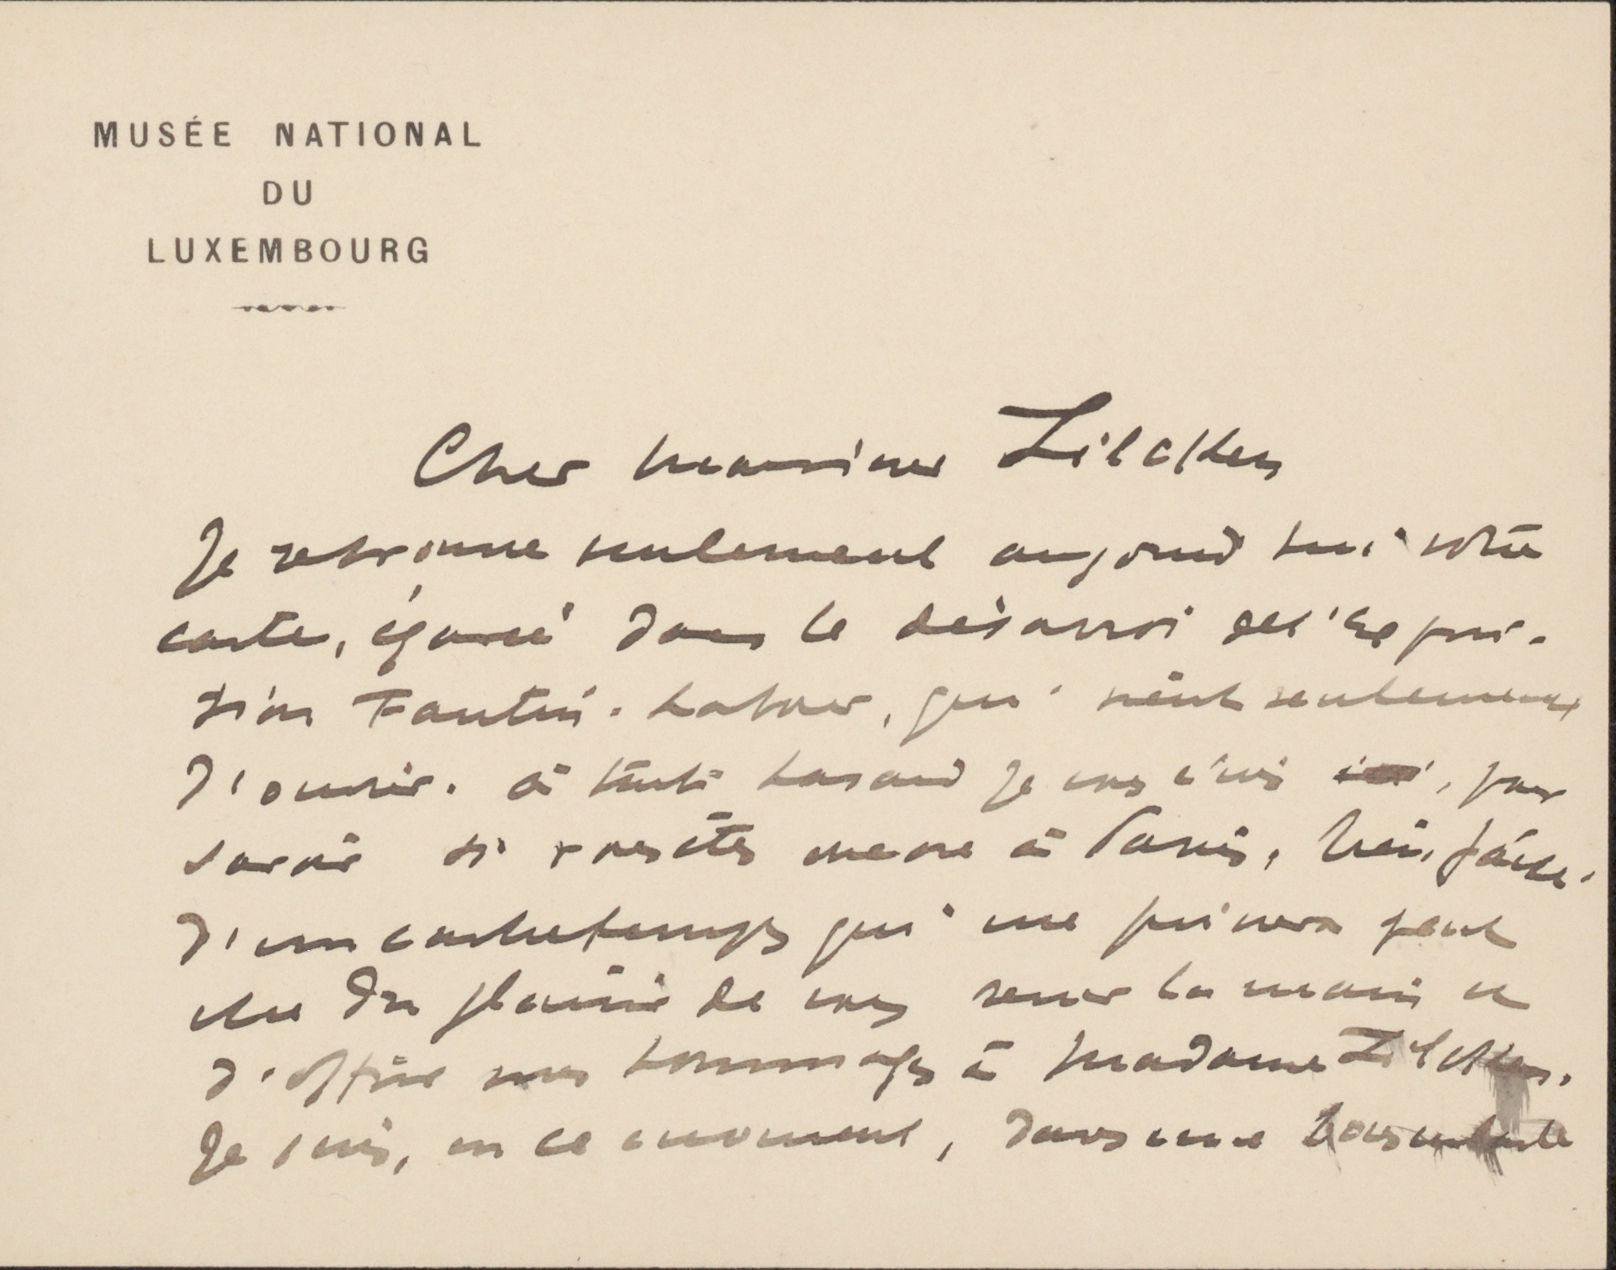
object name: letter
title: Brief aan Philip Zilcken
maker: léonce bénédite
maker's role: conservator, museumdirecteur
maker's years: 1856-1925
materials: cardboard, ink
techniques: pen, printing, writing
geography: paris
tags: print maker, draughtsman, henri fantin-latour, the hague, painter, philip zilcken, temporary exhibition, 'salon', paris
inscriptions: collector's mark: ‘RPK’, name: ‘MUSÉE NATIONAL/ DU/ LUXEMBOURG’